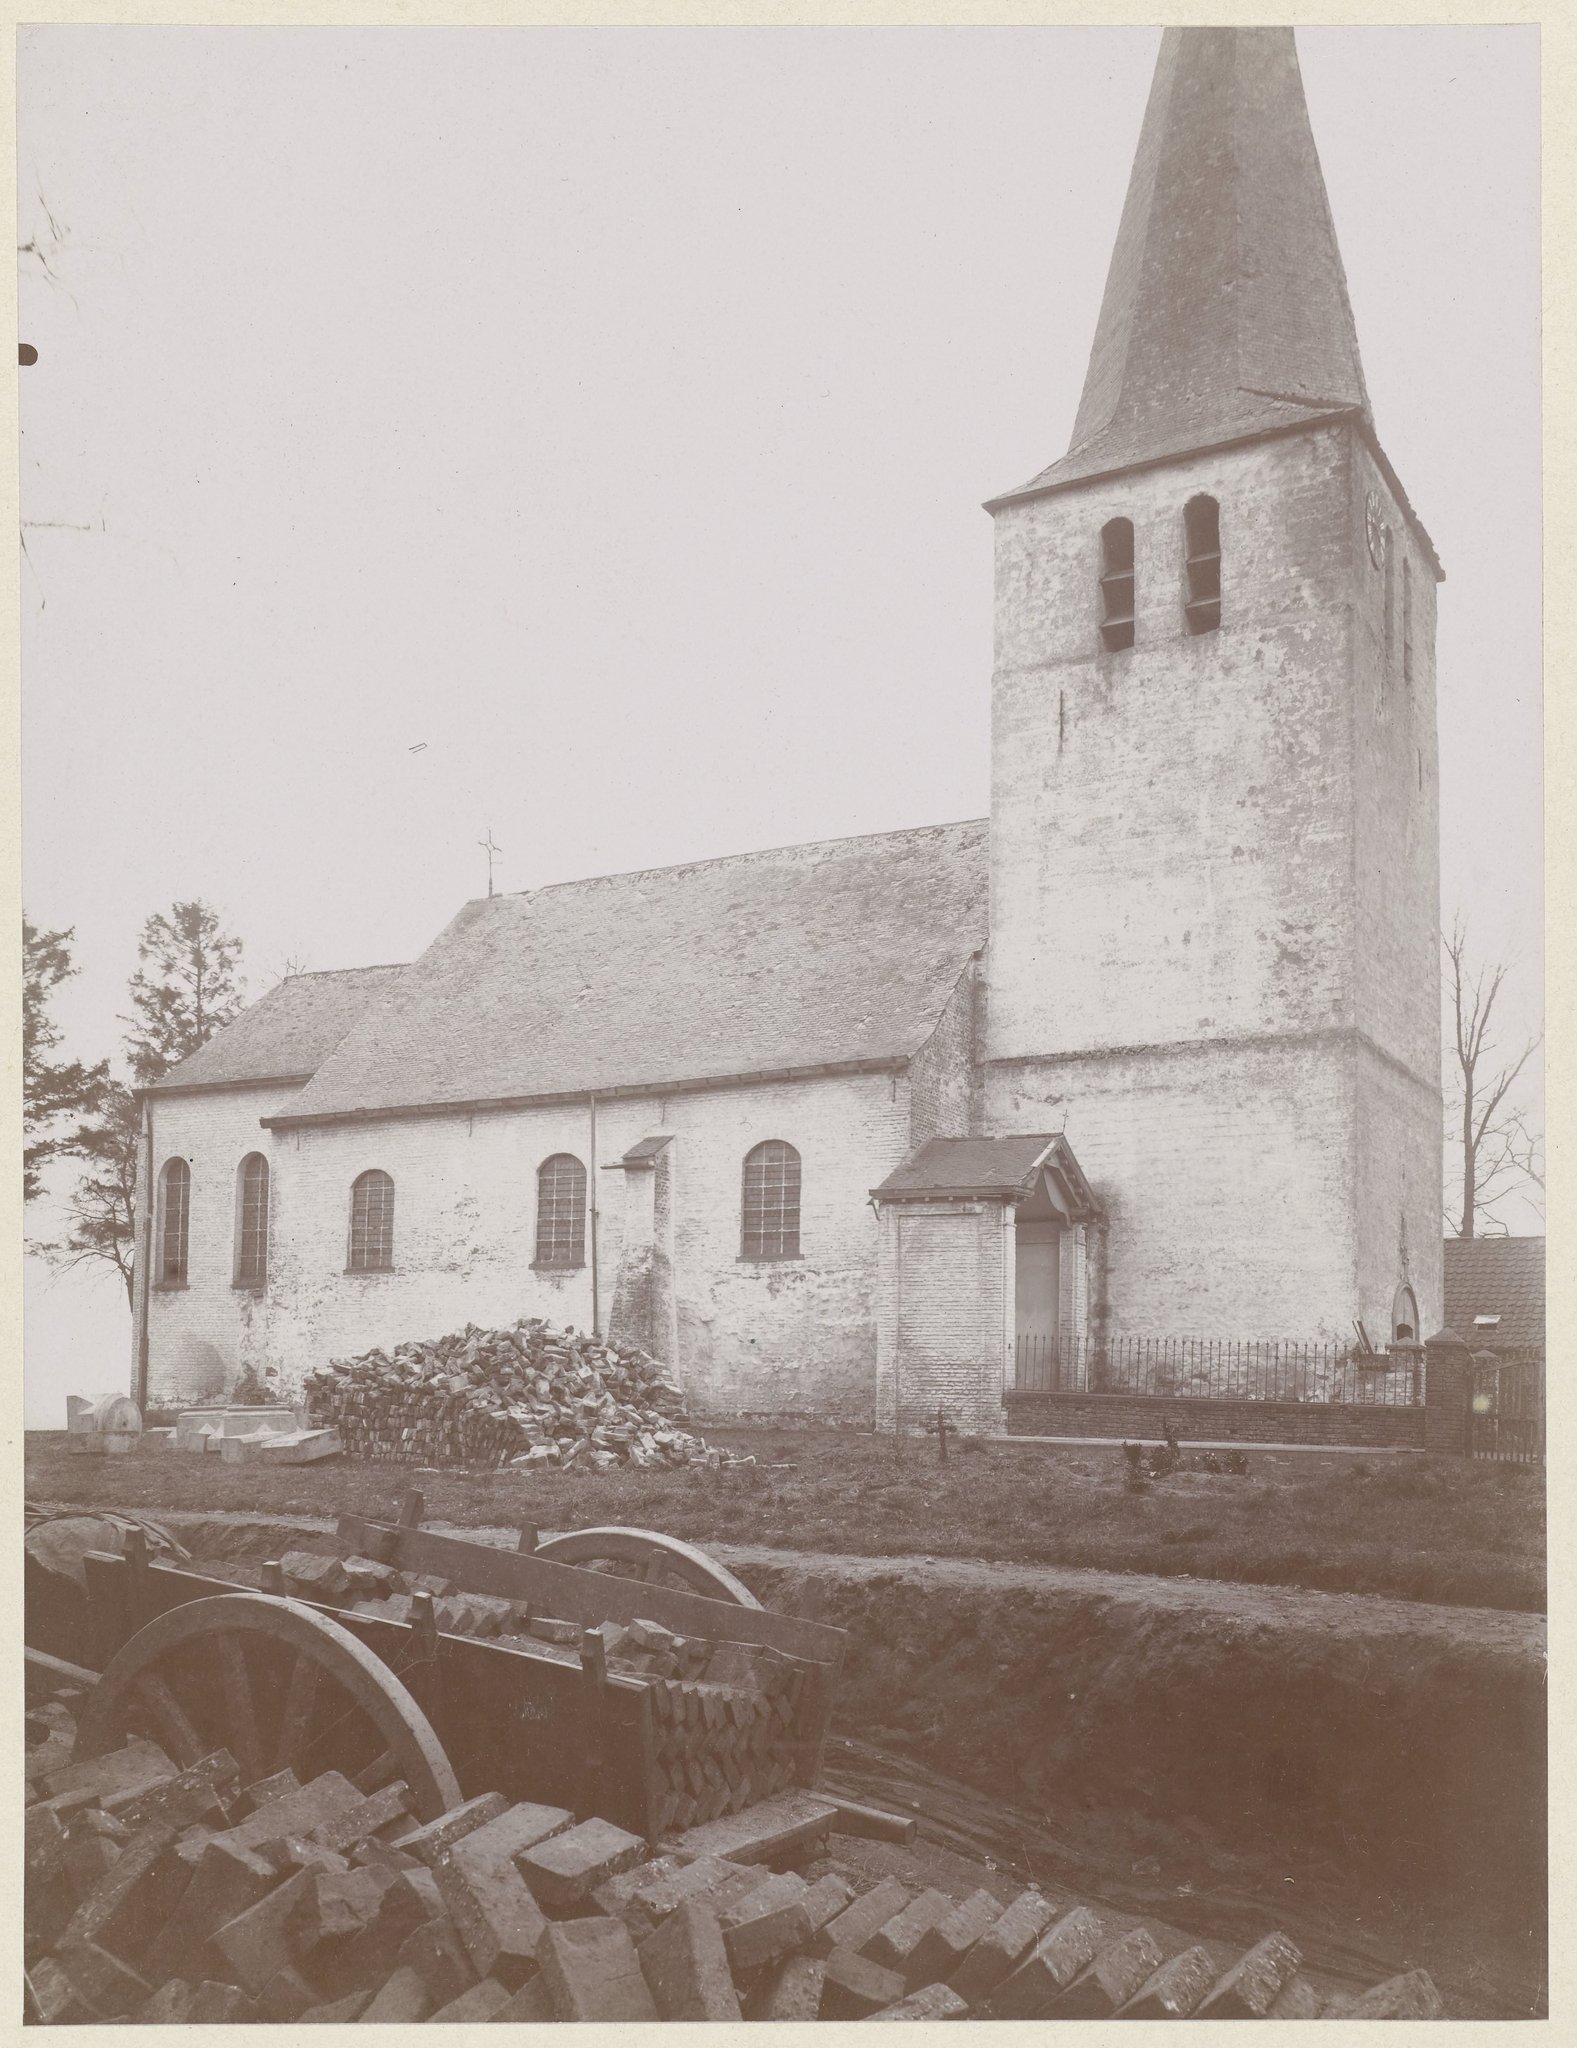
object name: photograph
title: Gezicht op de voormalige parochiekerk te Kessenich, met op de voorgrond een kar en klinkers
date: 1890-1898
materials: cardboard, photographic support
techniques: gelatin silver print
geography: kessenich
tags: church (exterior)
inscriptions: annotation: ‘Kessenich’, annotation: ‘Belgie Kessenich 1/4 uur van Thorn. Noorzijde der kerk. Kerk in april 1898 afgebroken’